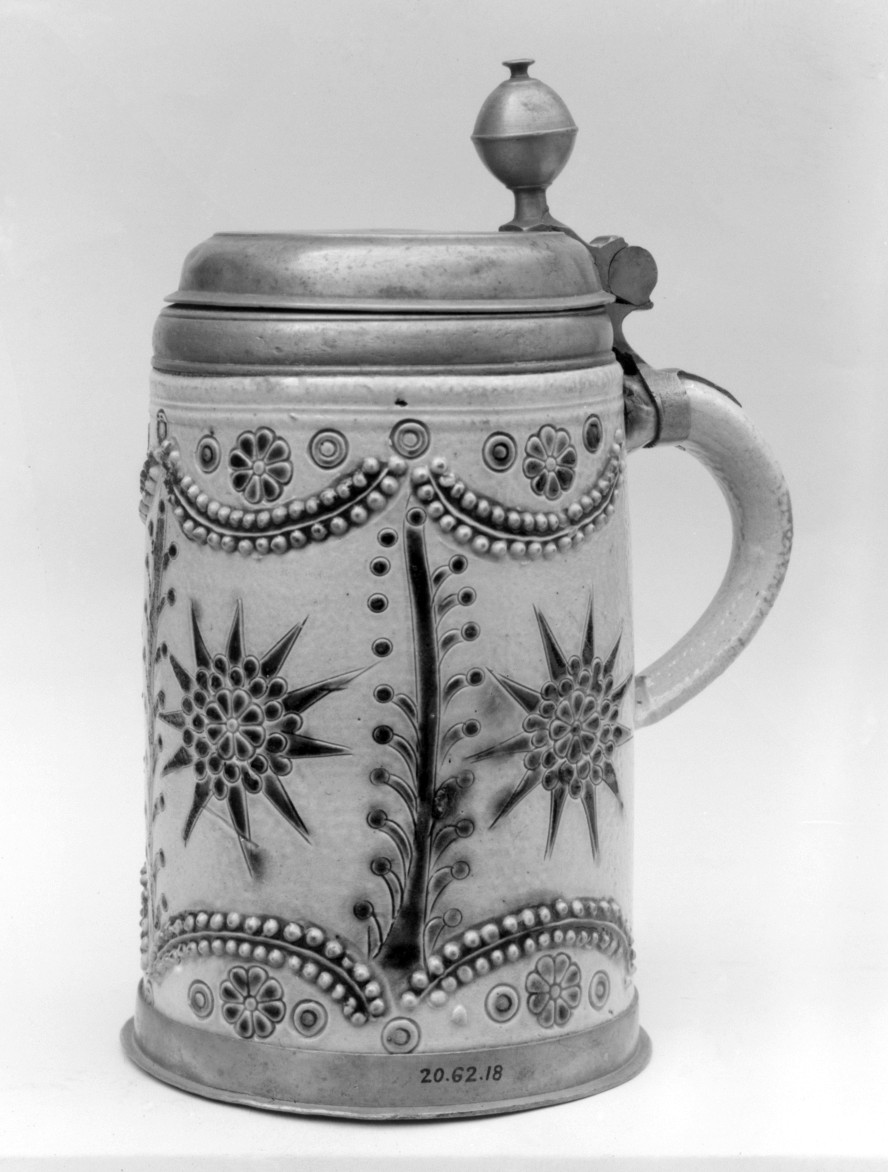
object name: tankard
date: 1601-1700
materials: pewter, stoneware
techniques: salt glaze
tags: flowers